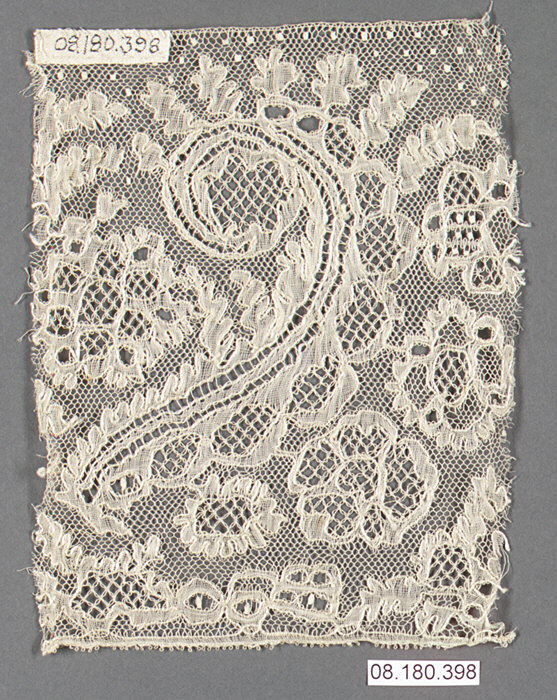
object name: fragment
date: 1801-1833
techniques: lace